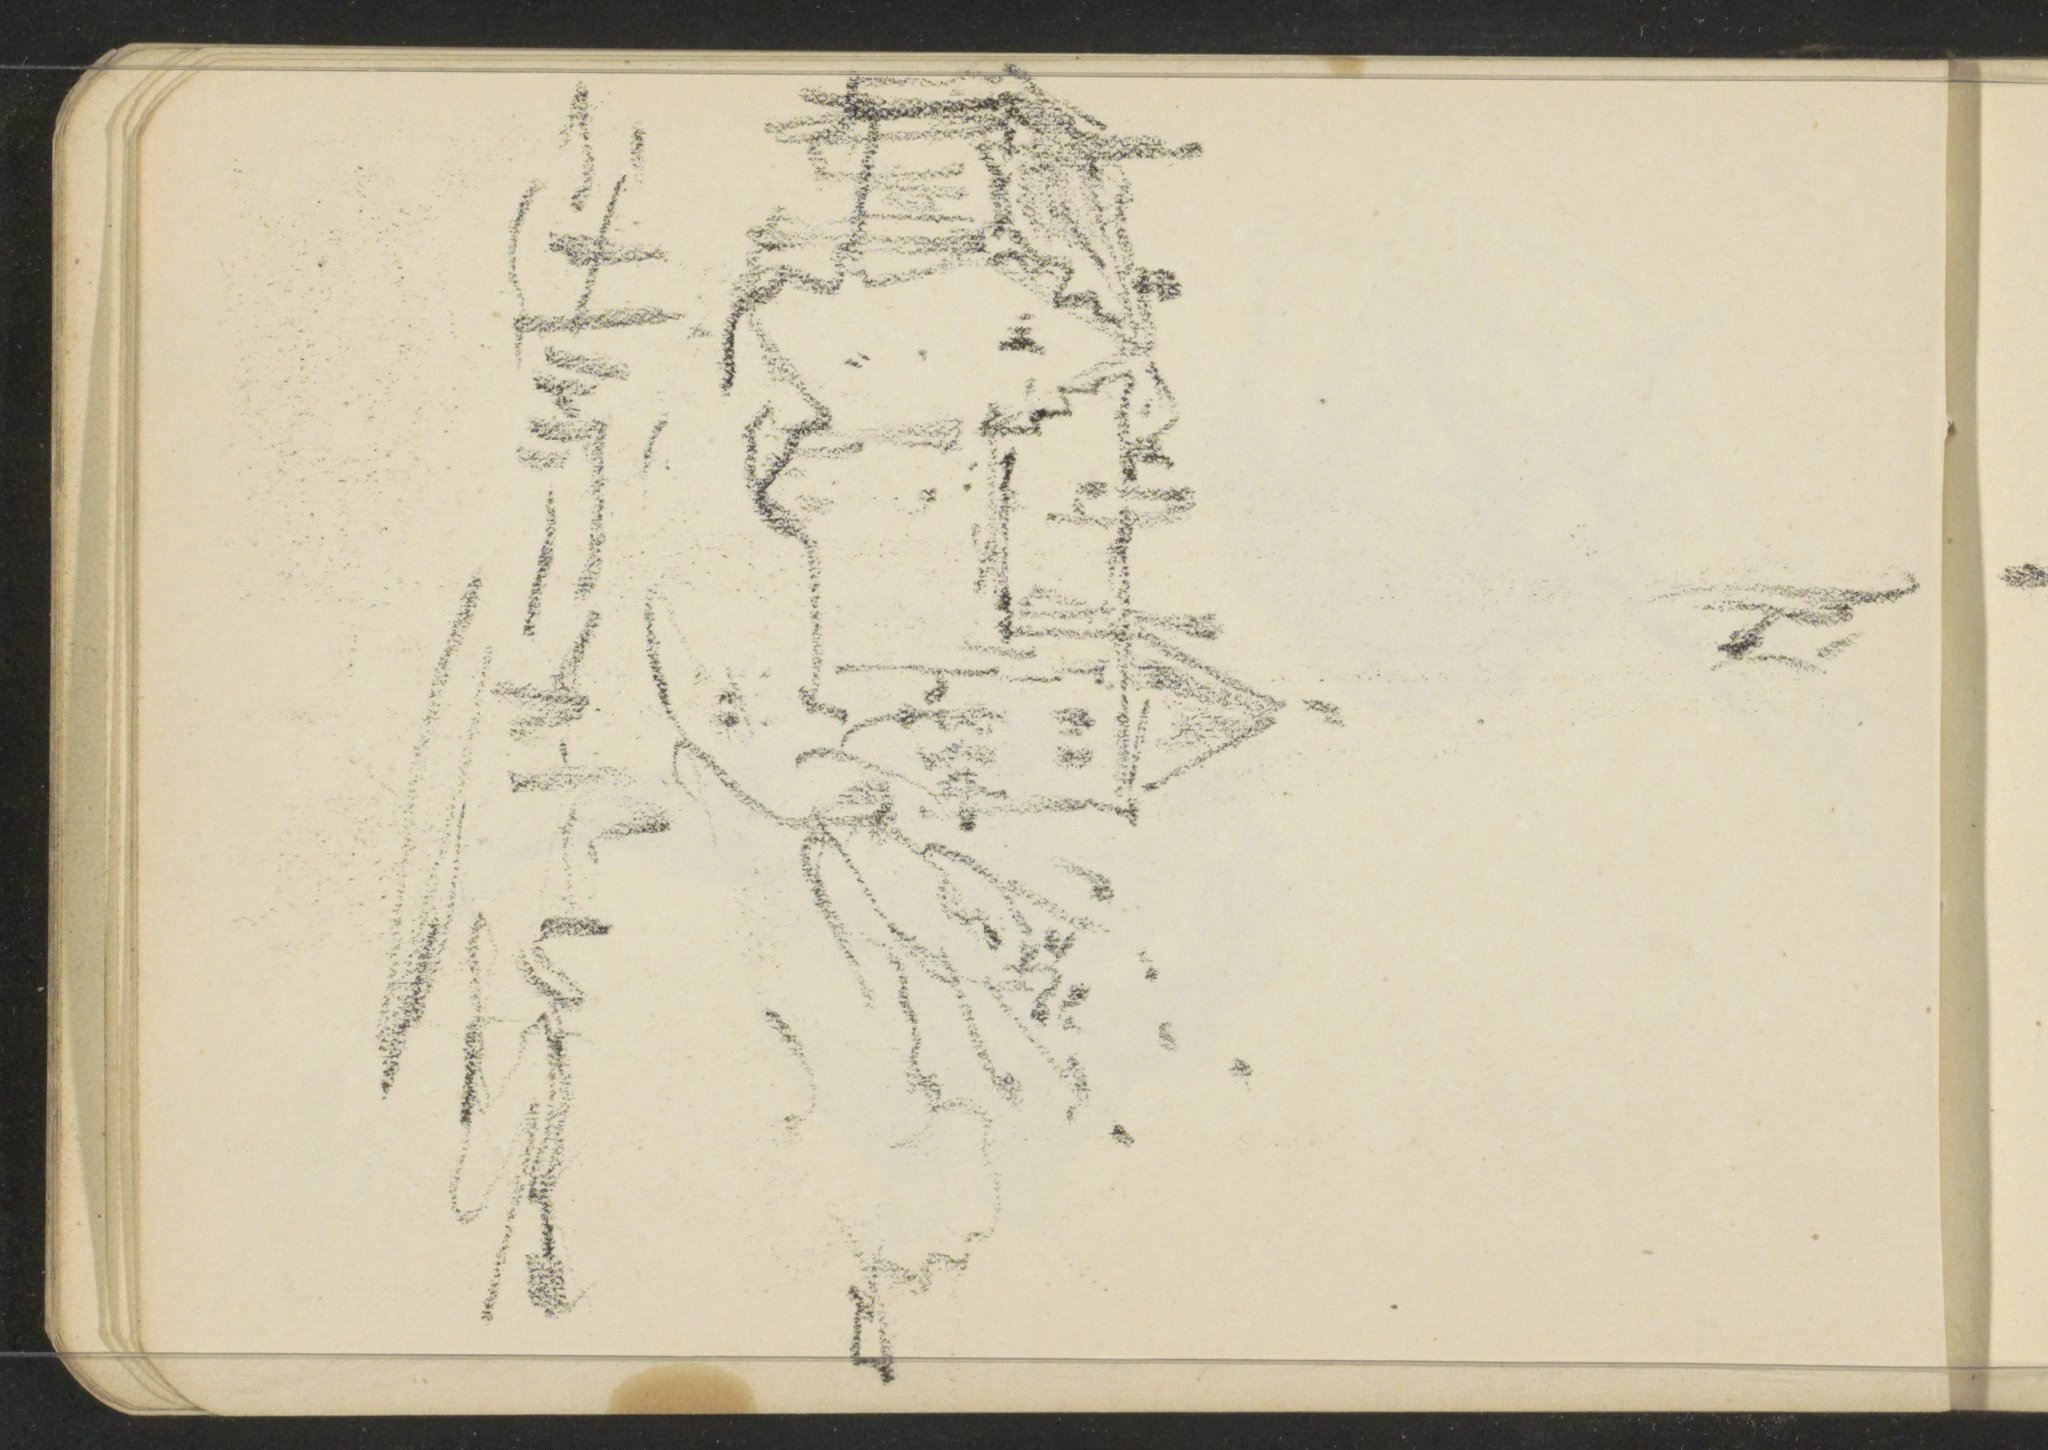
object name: sketchbook leaf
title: Gebouw met een trapgevel en toren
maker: willem cornelis rip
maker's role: draughtsman, painter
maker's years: 1856-1922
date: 1914-1916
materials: chalk, paper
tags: exterior ~ representation of a building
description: Blad 12 verso uit een schetsboek met 41 bladen.